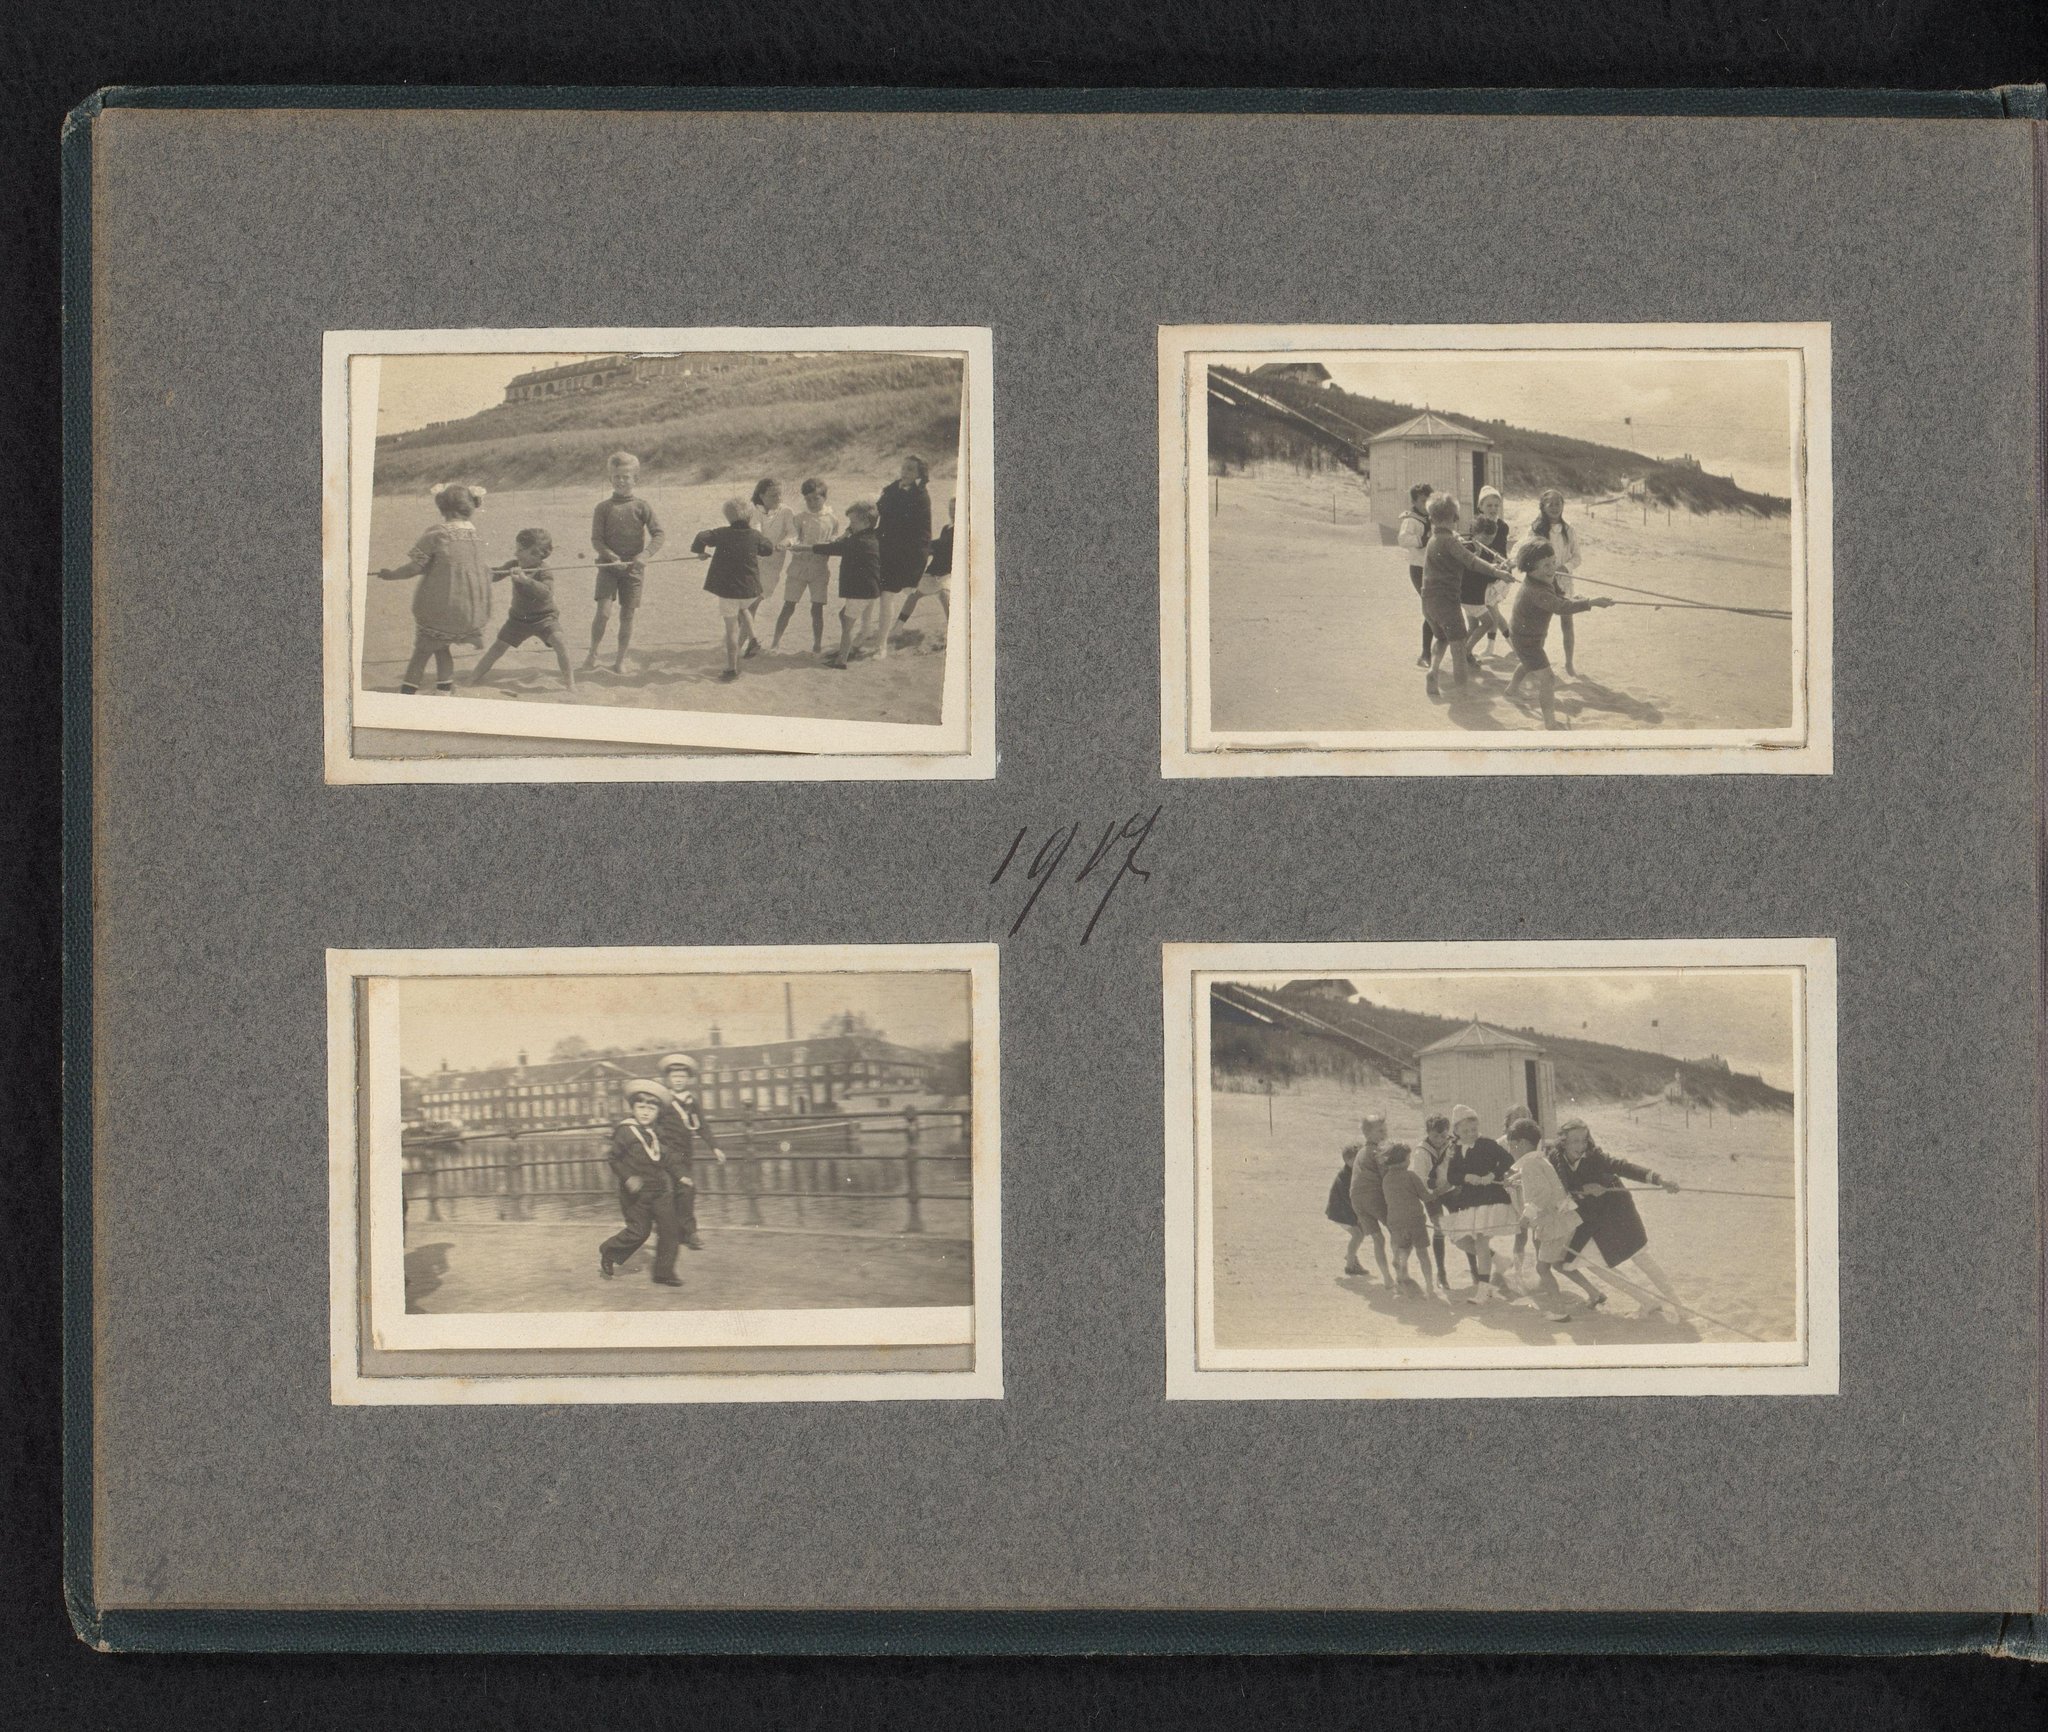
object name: album leaf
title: Kinderen, waaronder Carel en Frank van den Berg, op een strand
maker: hendrik herman van den berg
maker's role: amateurfotograaf, jurist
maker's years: 1875-1944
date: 1917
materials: paper, cardboard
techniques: gelatin silver print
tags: amsterdam, carel frederik van den berg (cay), frank willem van den berg (1912-1998), beach (as place of recreation)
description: Deze foto's zijn onderdeel van een album.